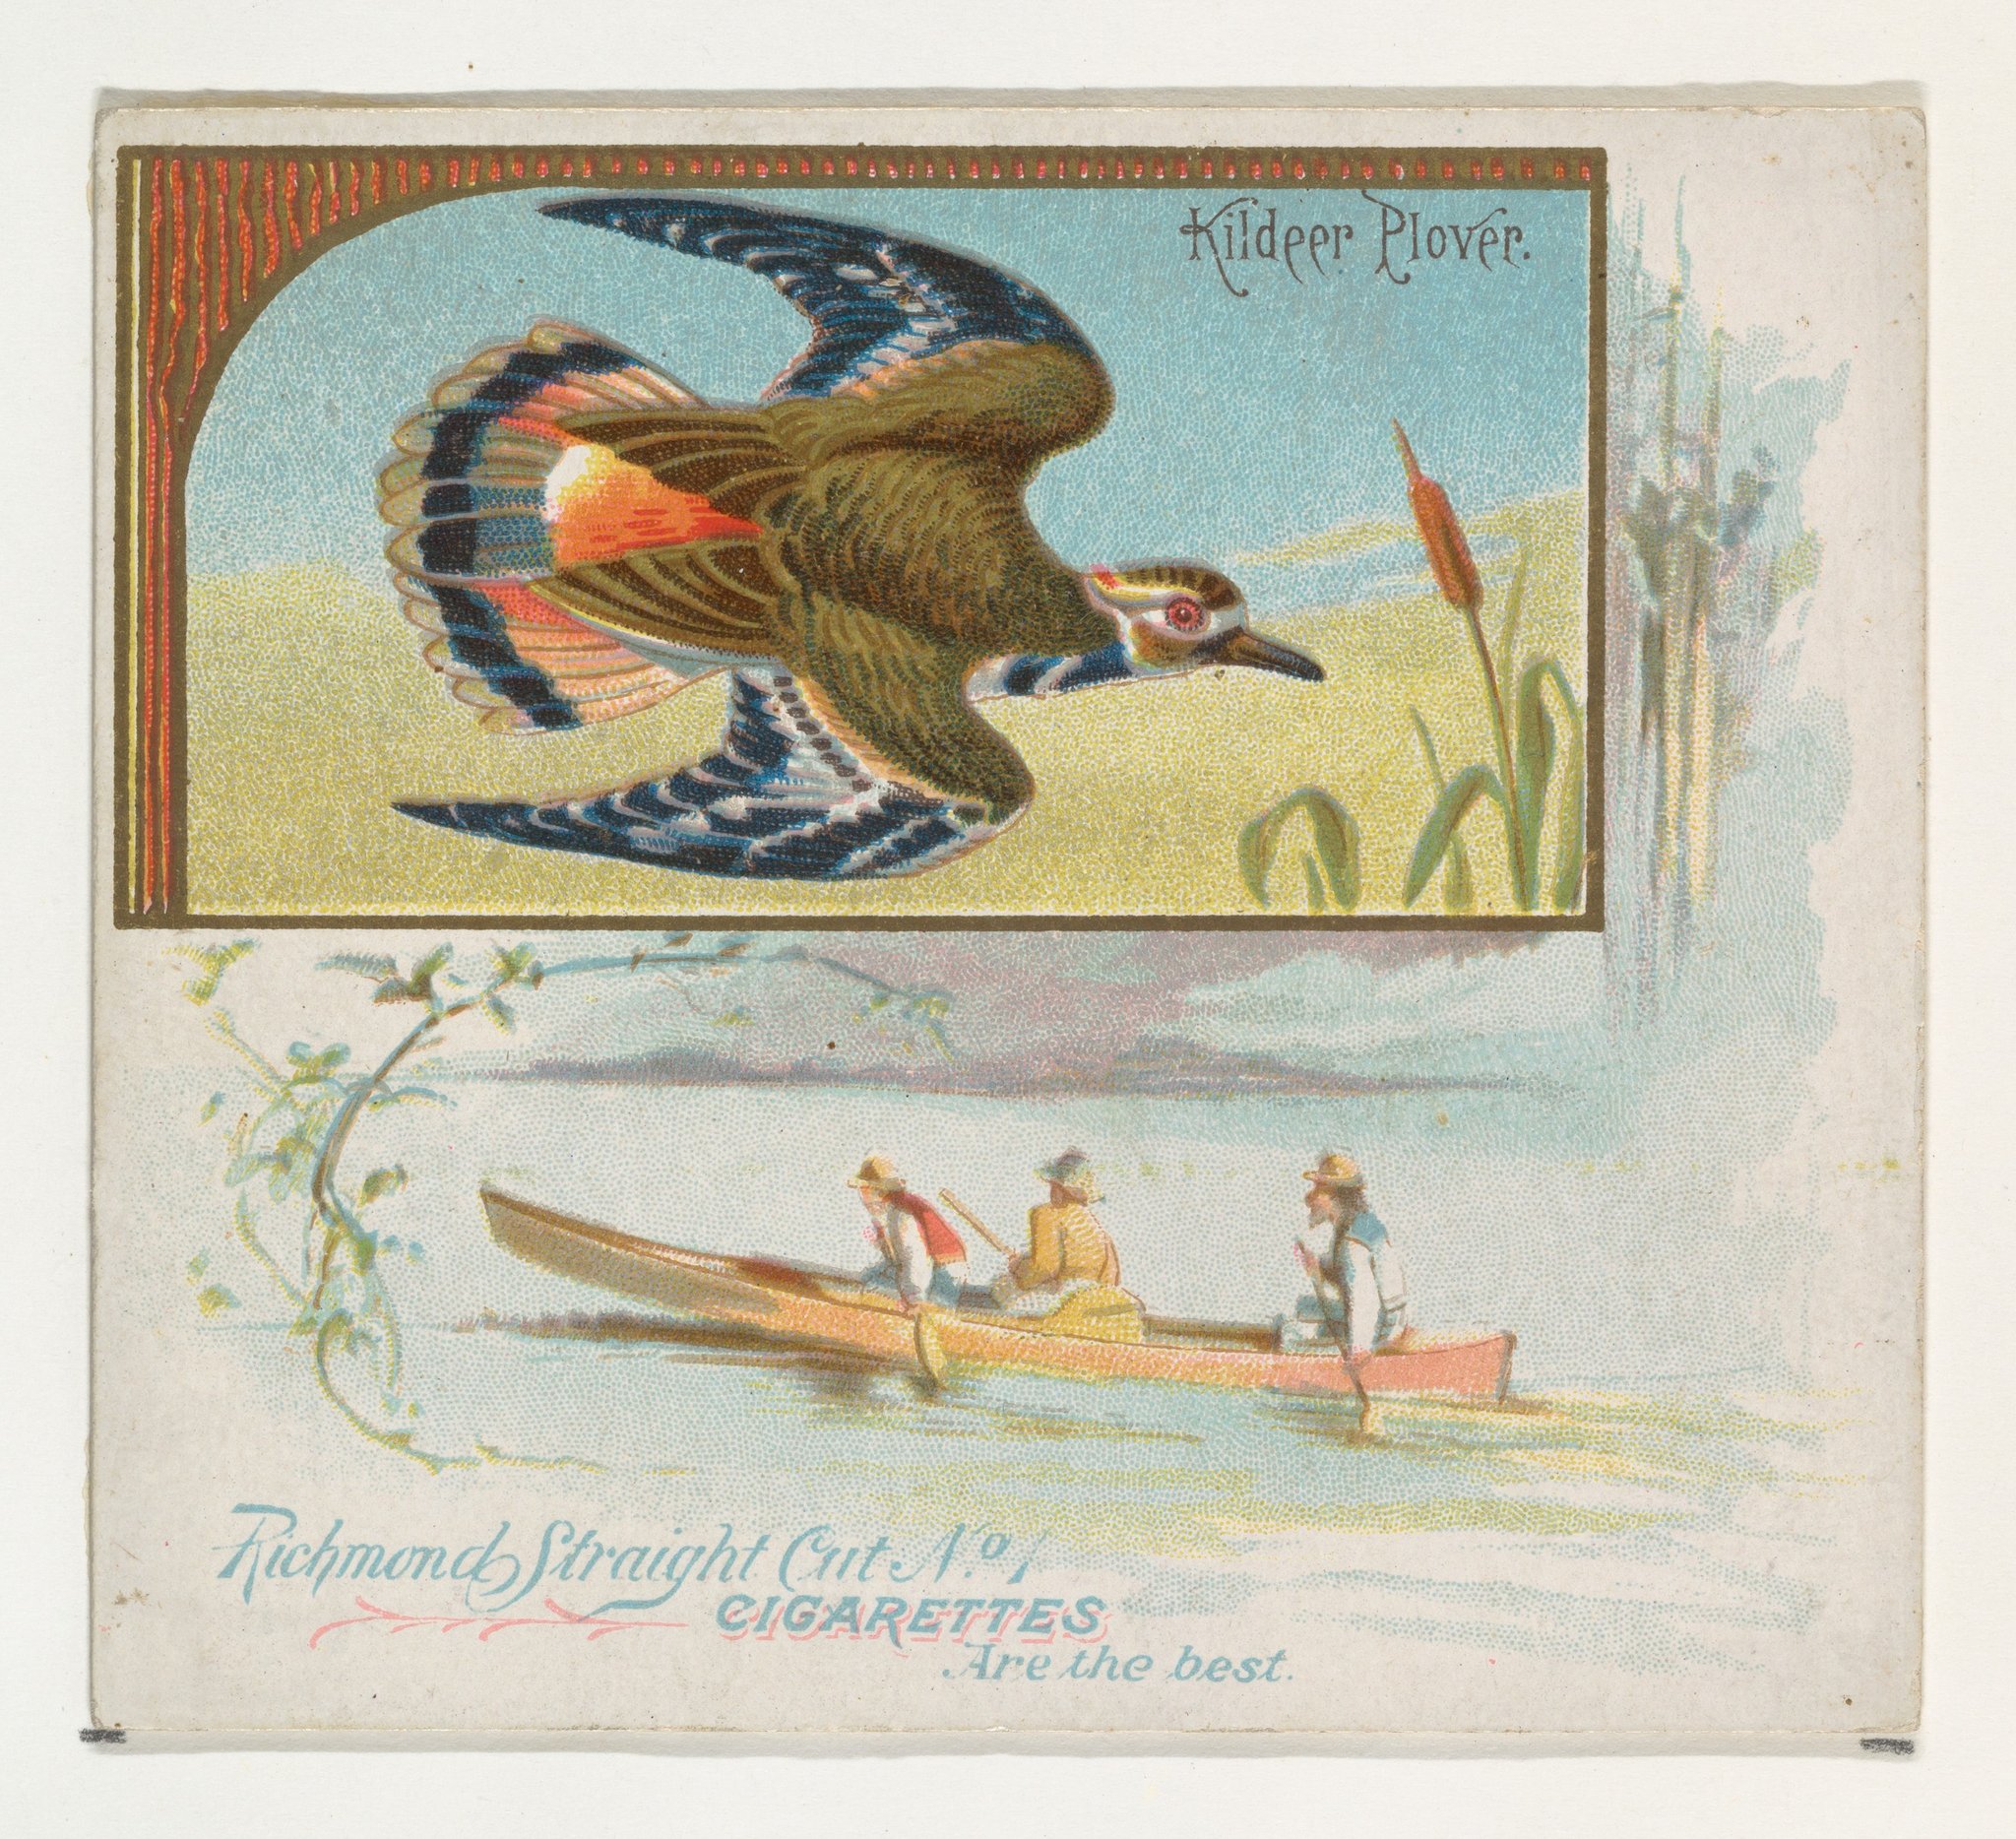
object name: print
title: Kildeer Plover, from the Game Birds series (N40) for Allen & Ginter Cigarettes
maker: allen & ginter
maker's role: publisher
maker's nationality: american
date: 1888-1890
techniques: color lithograph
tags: birds,boats